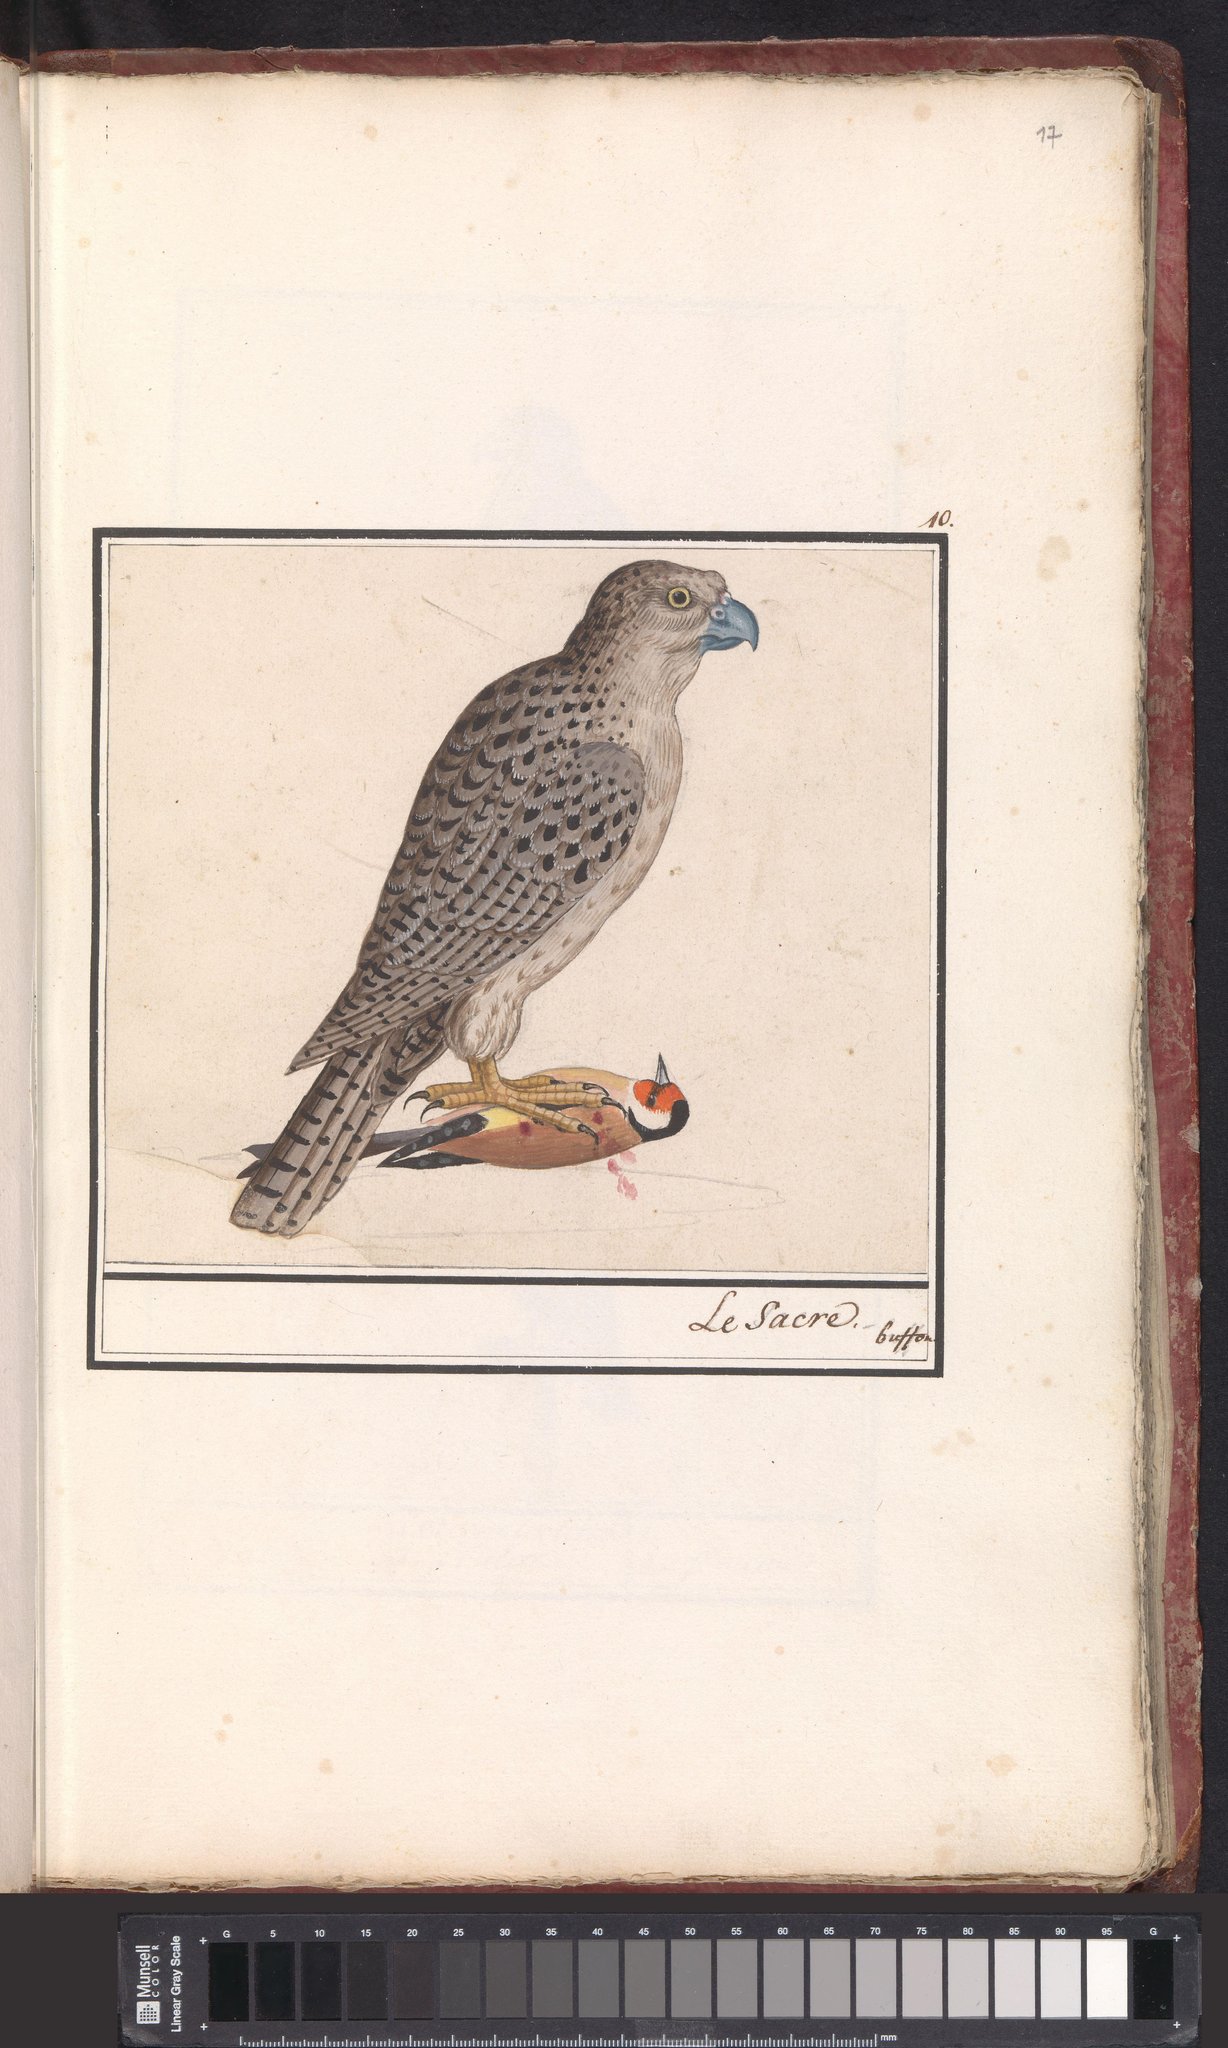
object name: drawing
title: Giervalk (Falco rusticolus)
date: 1596-1610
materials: paint, paper, pencil, watercolor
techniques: brush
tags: predatory birds: gyrfalcon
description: Giervalk met een gevangen vogel in de klauwen. Genummerd rechtsboven: 10. Onderdeel van het eerste album met tekeningen van vogels. Derde van twaalf albums met tekeningen van dieren, vogels en planten bekend rond 1600, gemaakt in opdracht van keizer Rudolf II. Met toelichting in Nederlands, Latijn en Frans.